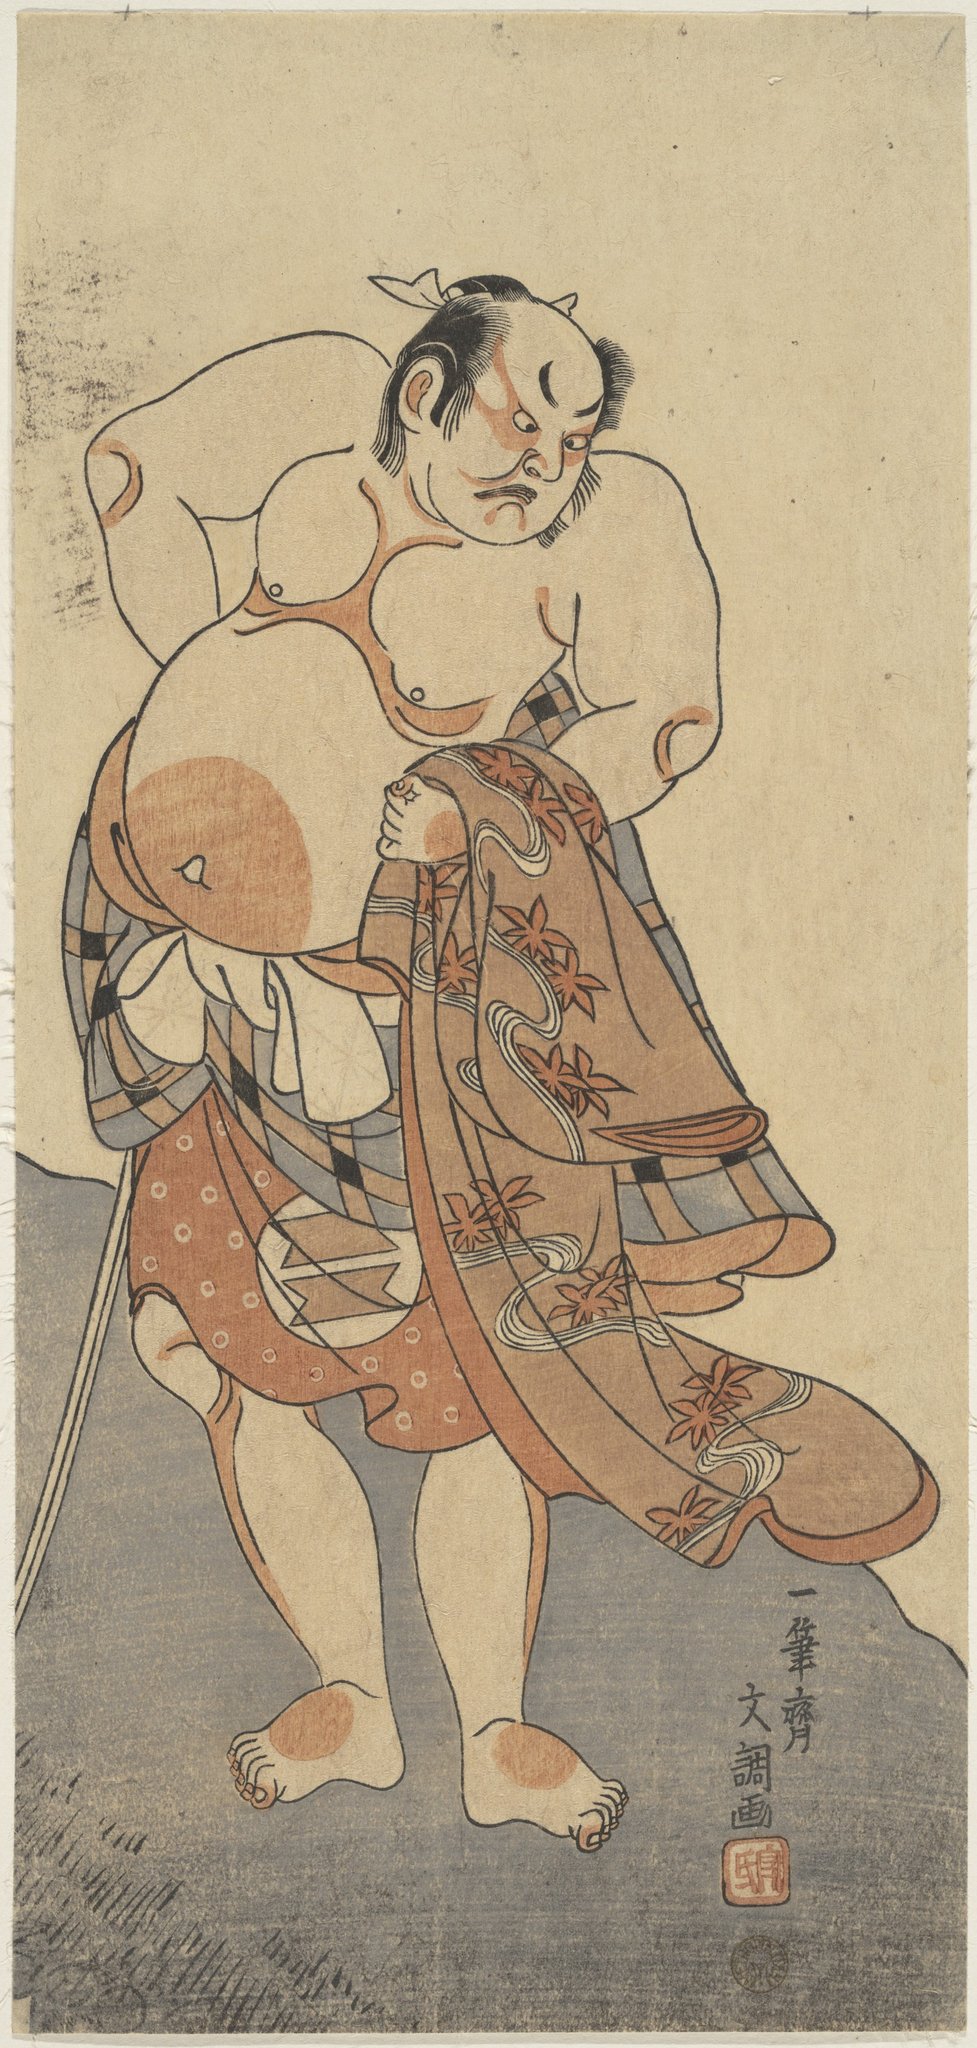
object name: print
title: Actor Sakata Hongoro II as a Wrestler in a Play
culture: japanese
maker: ippitsusai bunchō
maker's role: artist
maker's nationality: japanese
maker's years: 1765-1792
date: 1770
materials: ink, paper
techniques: woodblock print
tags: men,actors